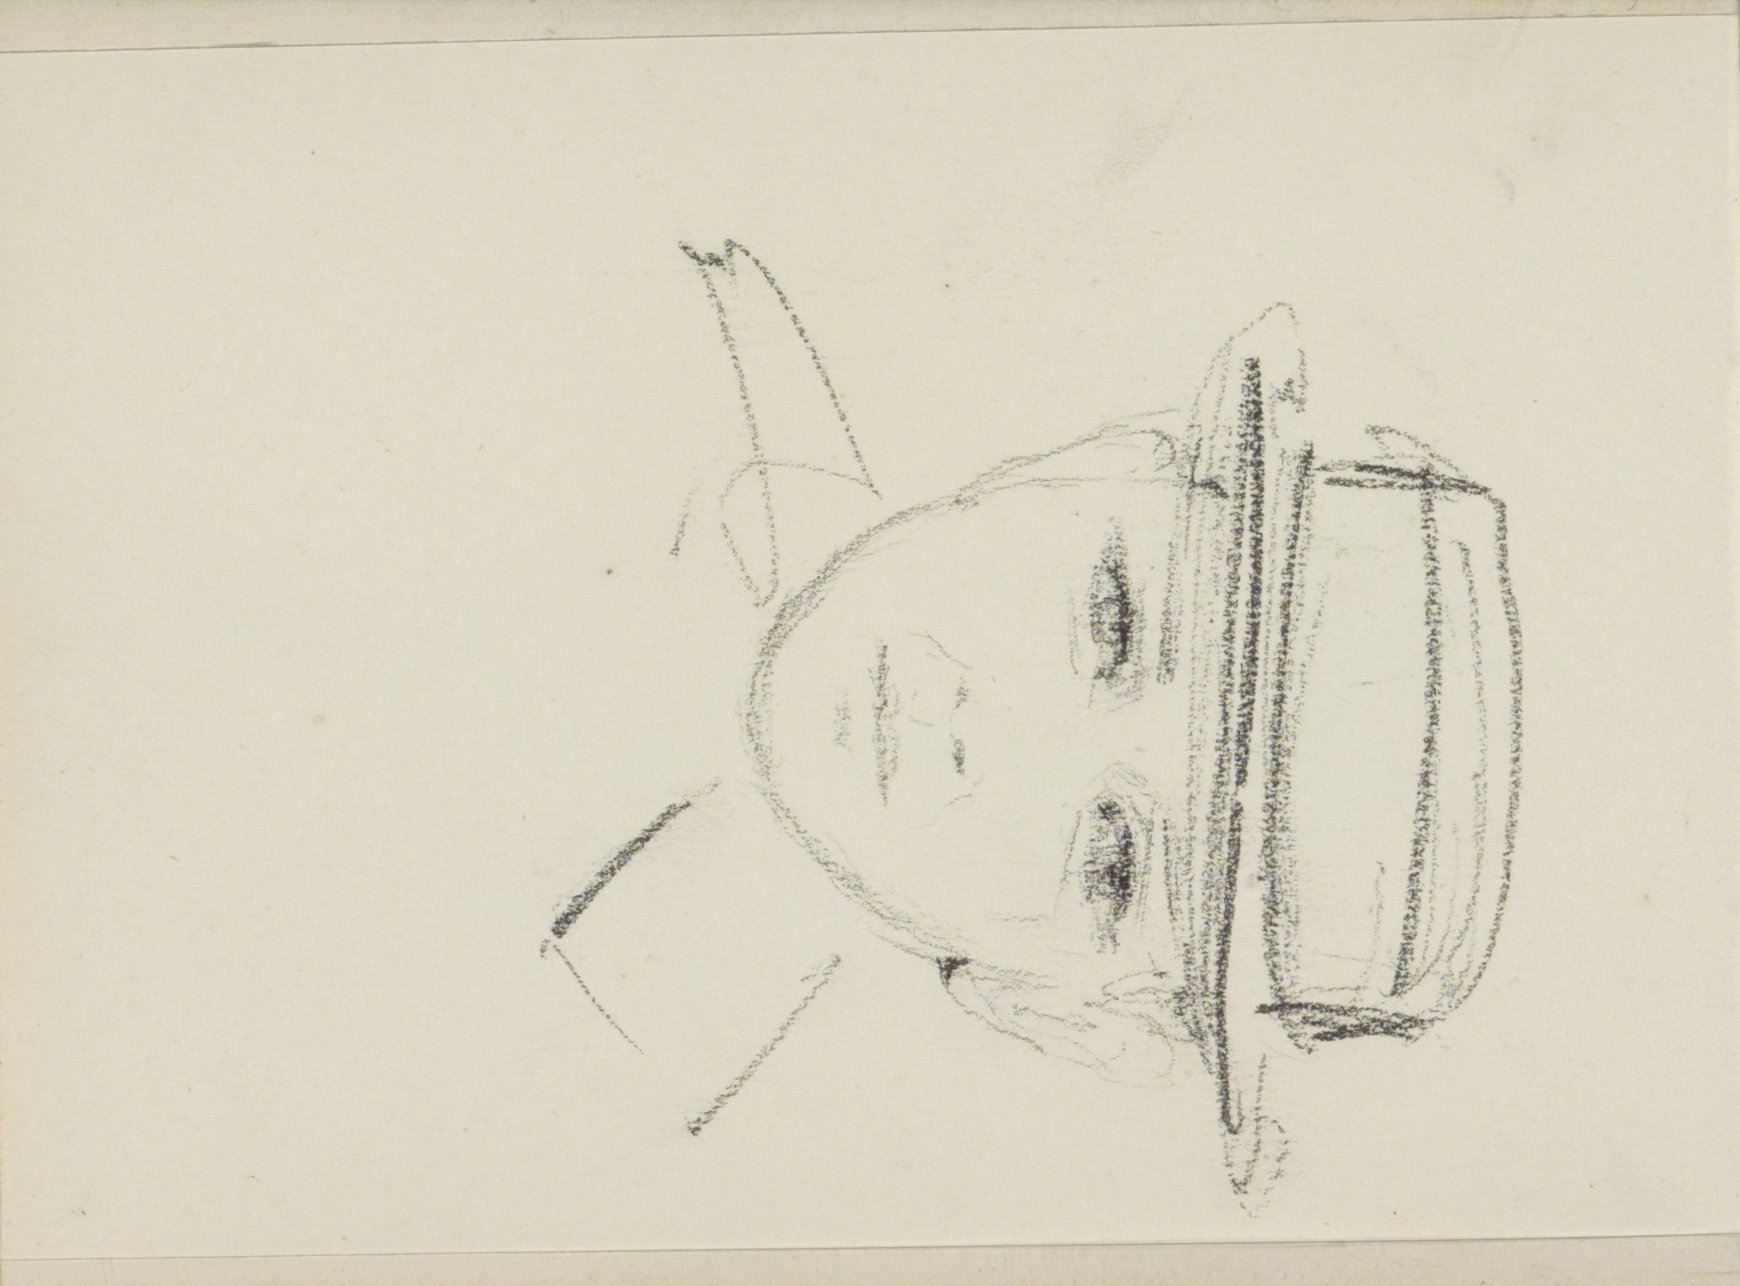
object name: sketchbook leaf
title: Jongen met een platte hoed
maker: a.a.l. de grammont-hubrecht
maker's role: draughtsman, painter, print maker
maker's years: 1855-1913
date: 1865-1913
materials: chalk, paper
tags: boy (child between toddler and youth), head-gear: hat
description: Blad 23 verso uit een schetsboek met 38 bladen.